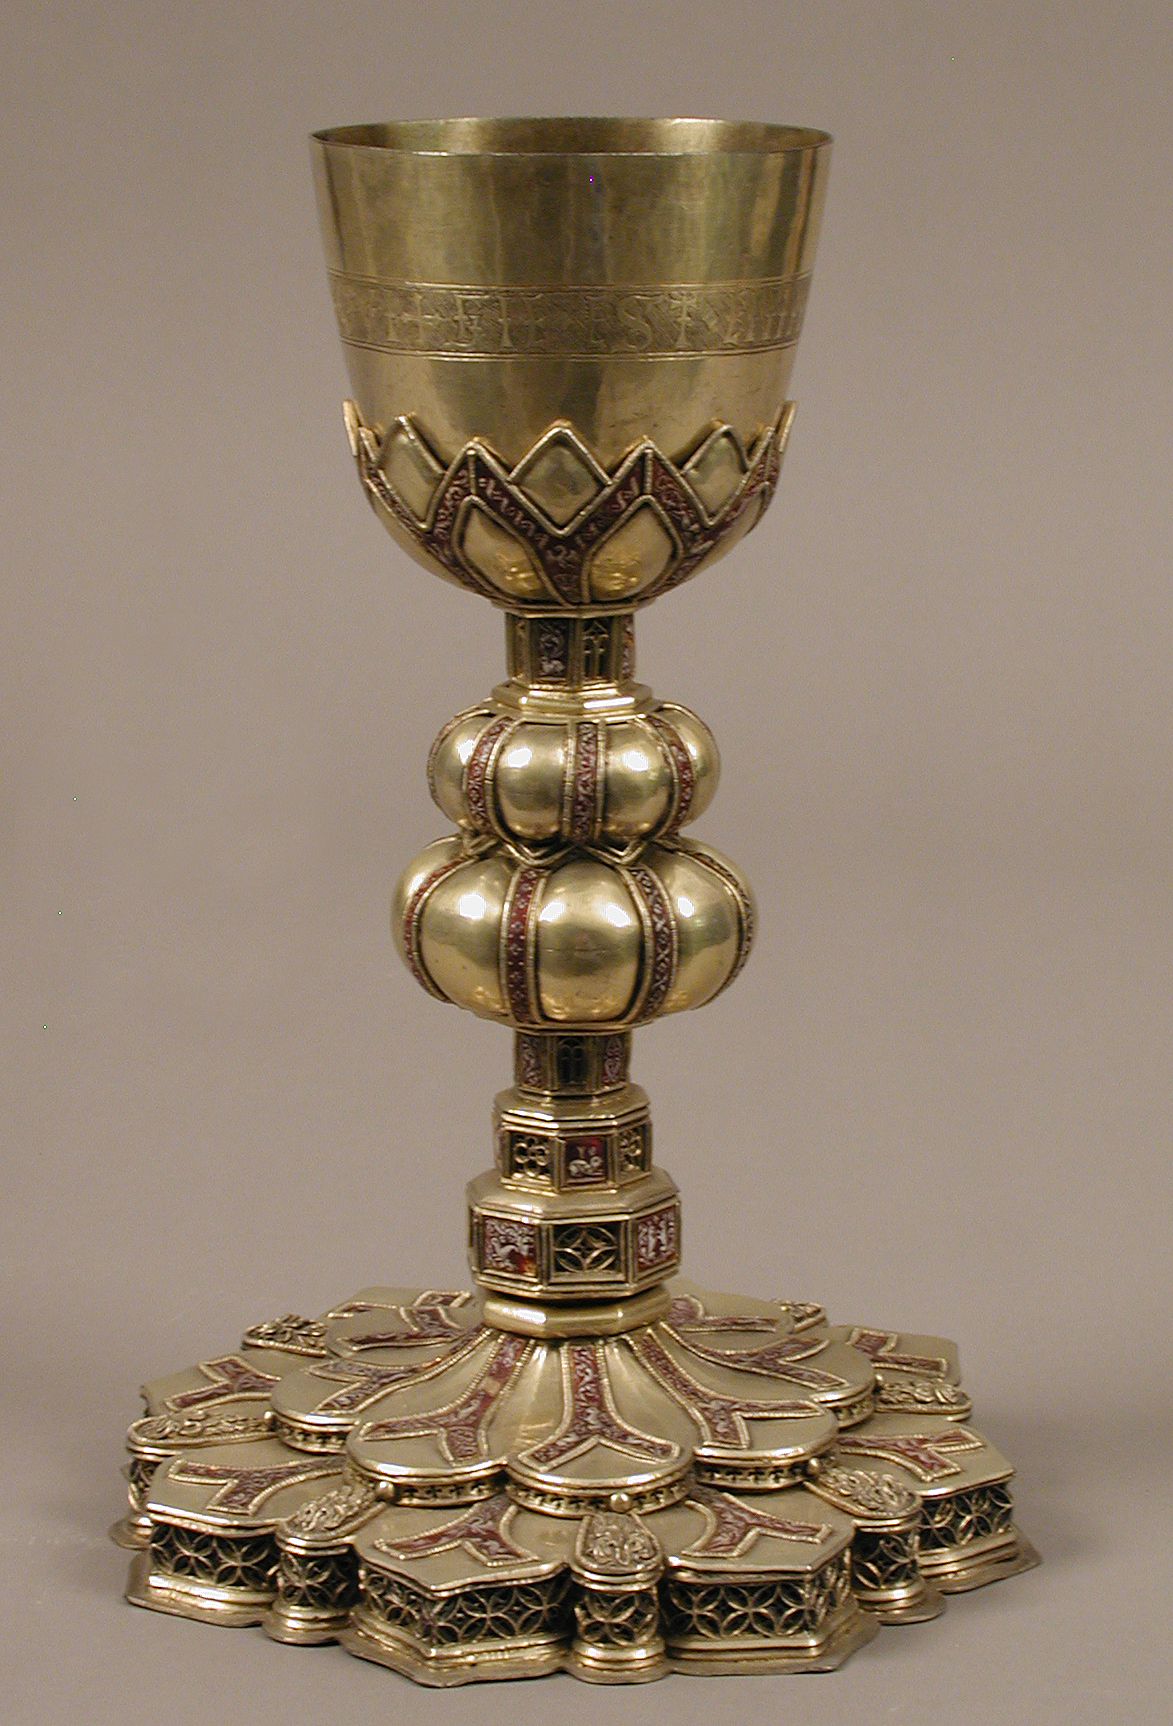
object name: chalice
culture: spanish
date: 1501-1550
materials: enamel, silver gilt